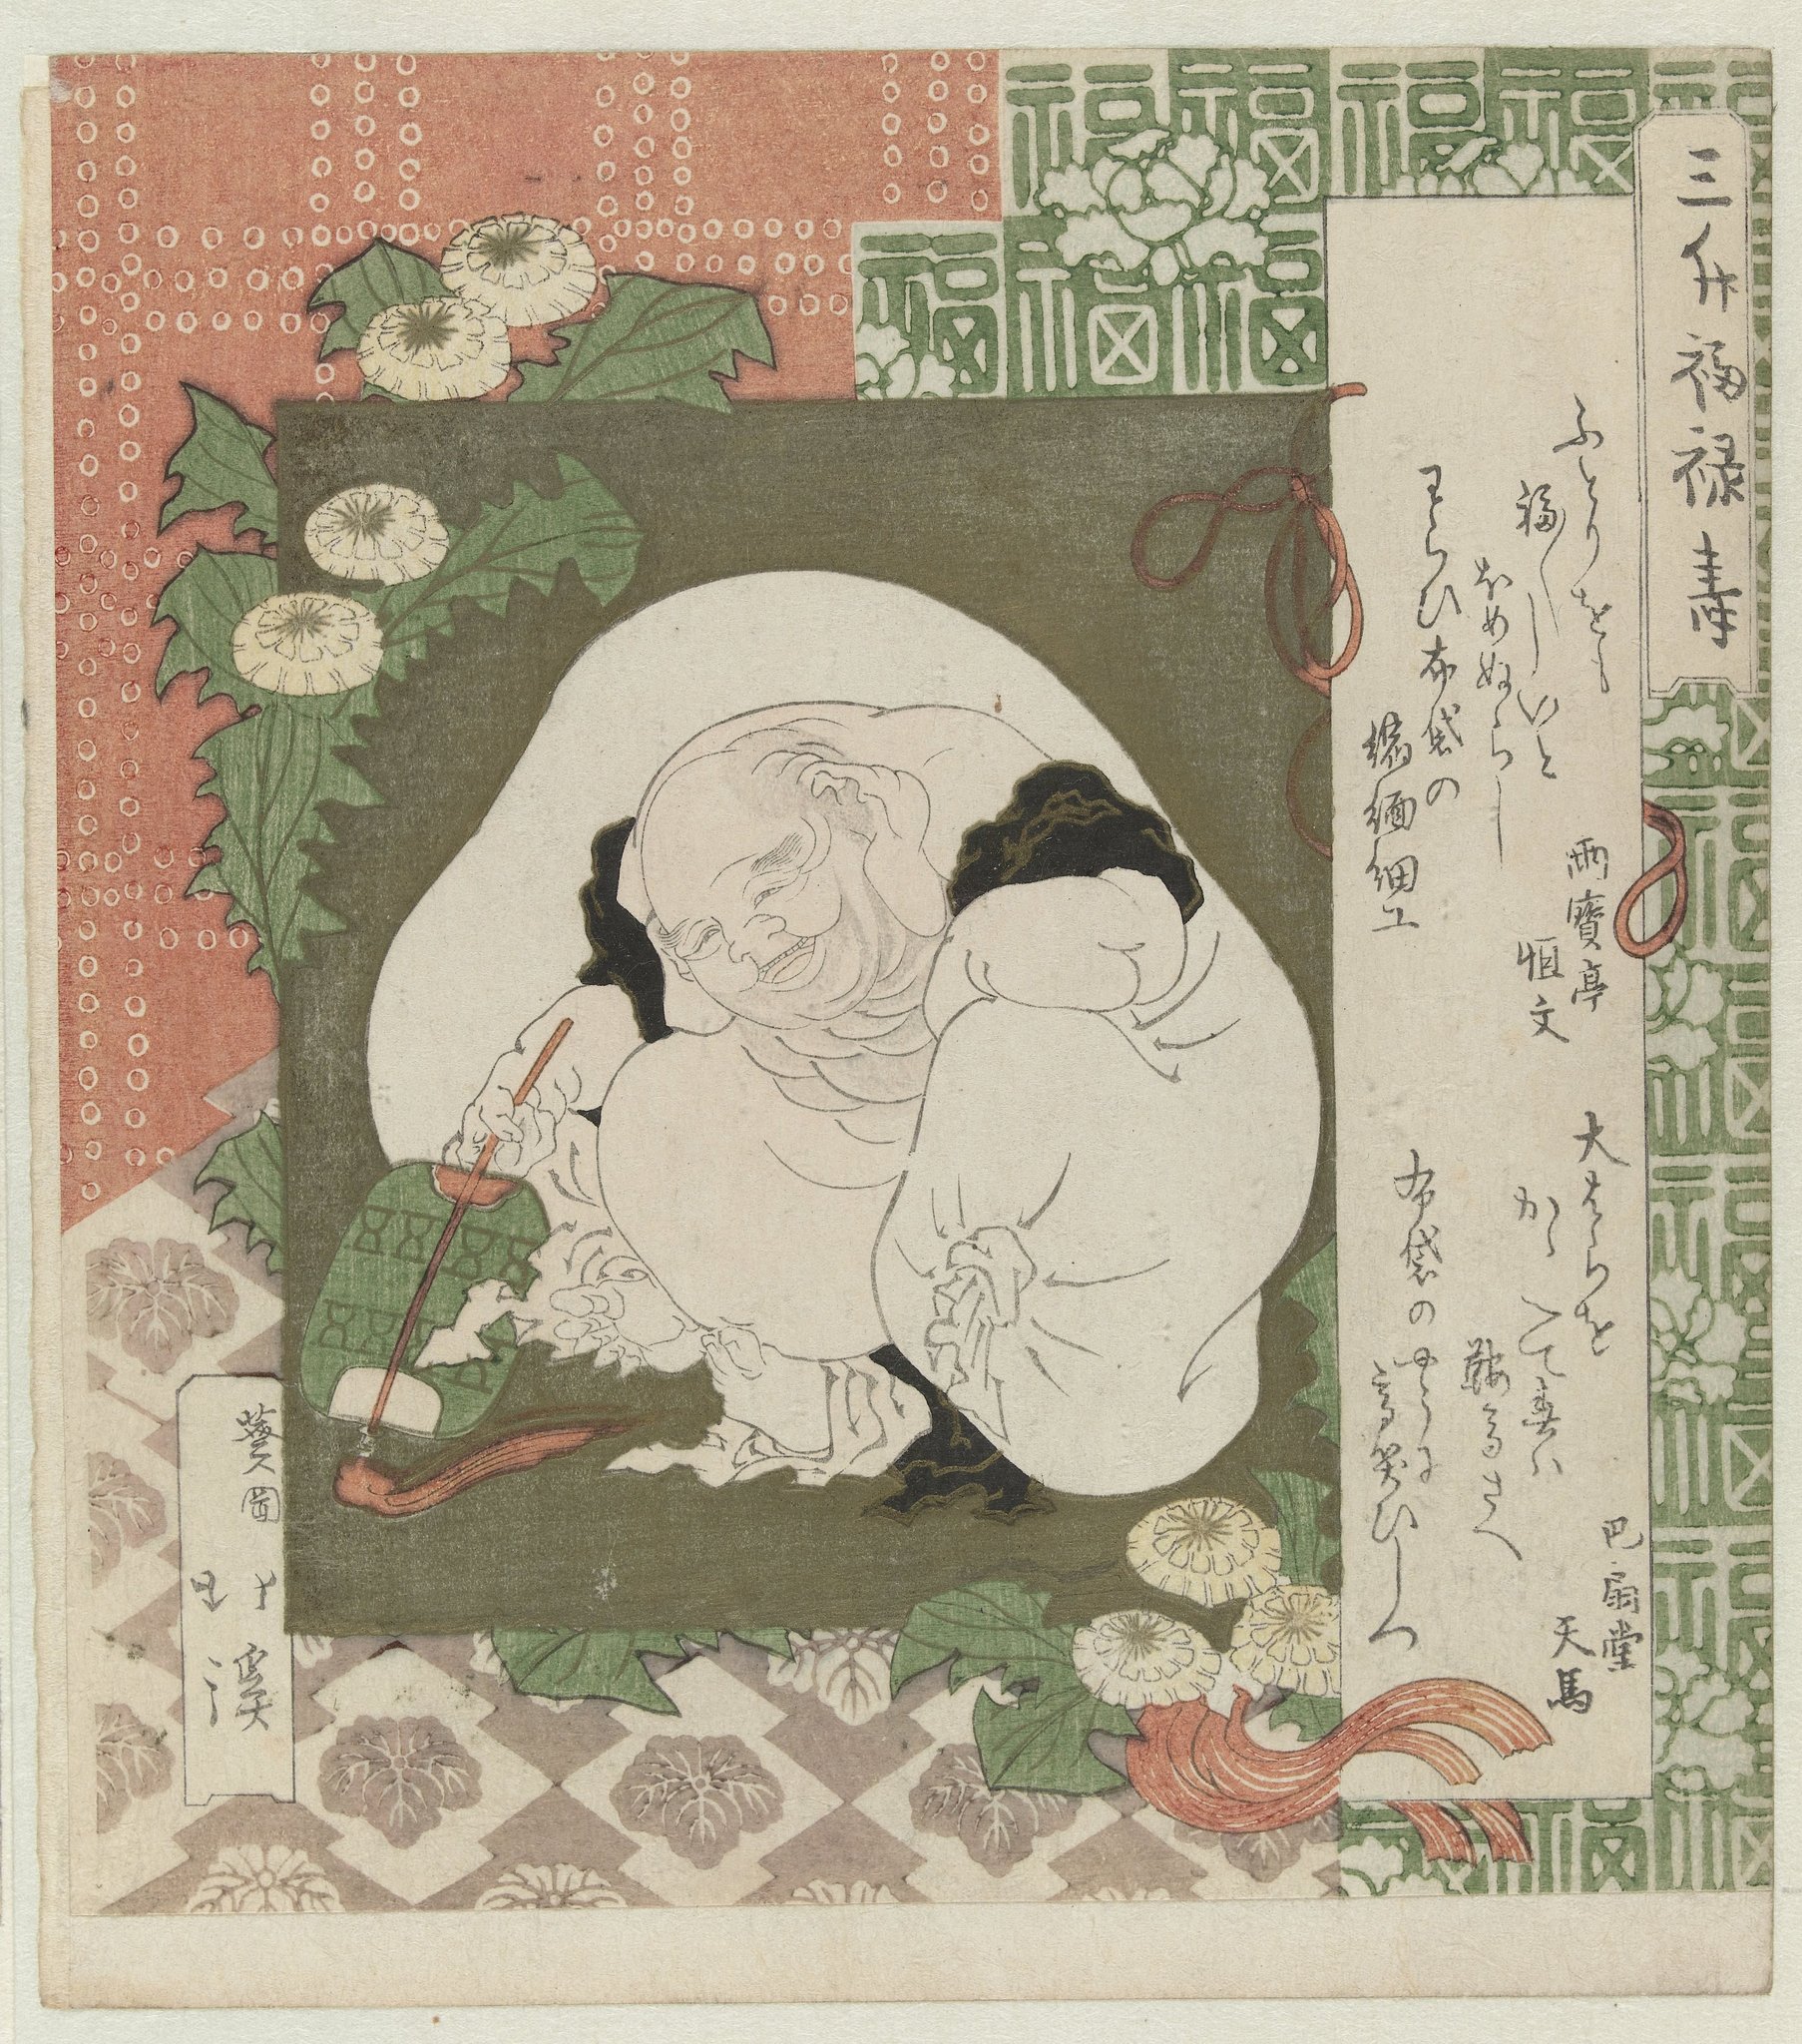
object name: surimono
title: Happiness and long life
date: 1823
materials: copper powder, paper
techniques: blind stamped, woodcut, nishiki e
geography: japan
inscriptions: collector's mark, verso, stamped: Lugt 2228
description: Een surimono is een luxe uitgevoerde prent waarop beeld met één of meerdere gedichten gecombineerd is. Bij het drukken van een surimono werd vaak gebruik gemaakt van dikker papier, blinddruk en metaal pigmenten, zoals koper- en zilverpoeder. De prenten werden vaak in opdracht van dichters gemaakt en als exclusief geschenk aan vrienden en relaties gegeven.